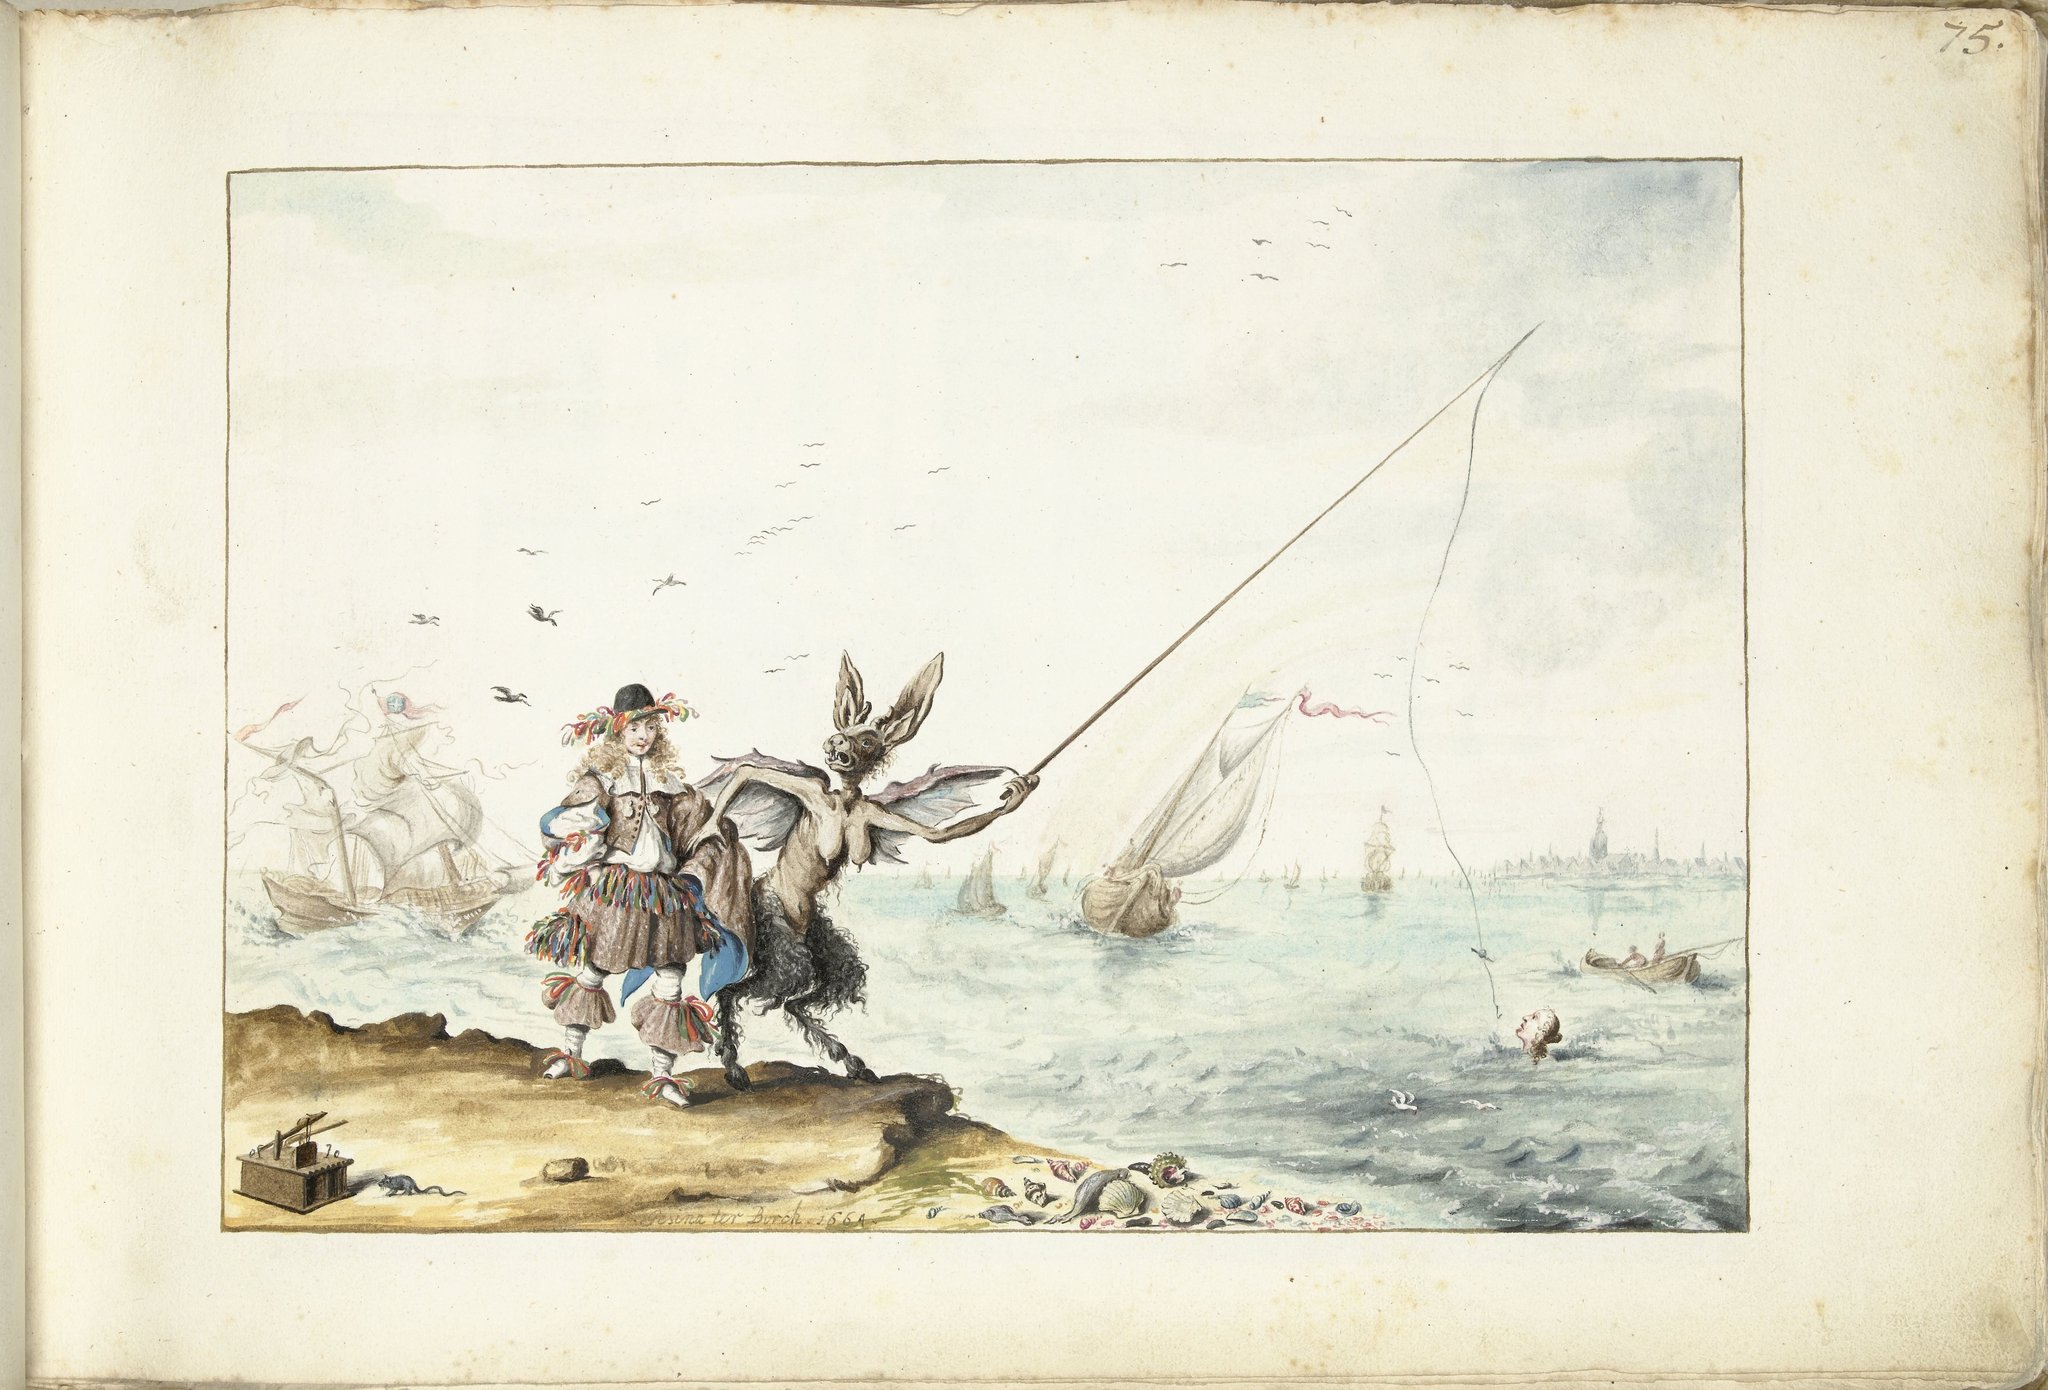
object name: drawing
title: Een heer (Moses?) wordt verleid door een duivel die naar een vrouw vist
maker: gesina ter borch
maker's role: draughtsman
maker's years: 1633-1690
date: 1664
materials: paper, watercolor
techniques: brush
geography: zwolle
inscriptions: signature and date: ‘Gesina ter Borch.1664.’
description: Allegorie op het leven van Moses ter Borch.